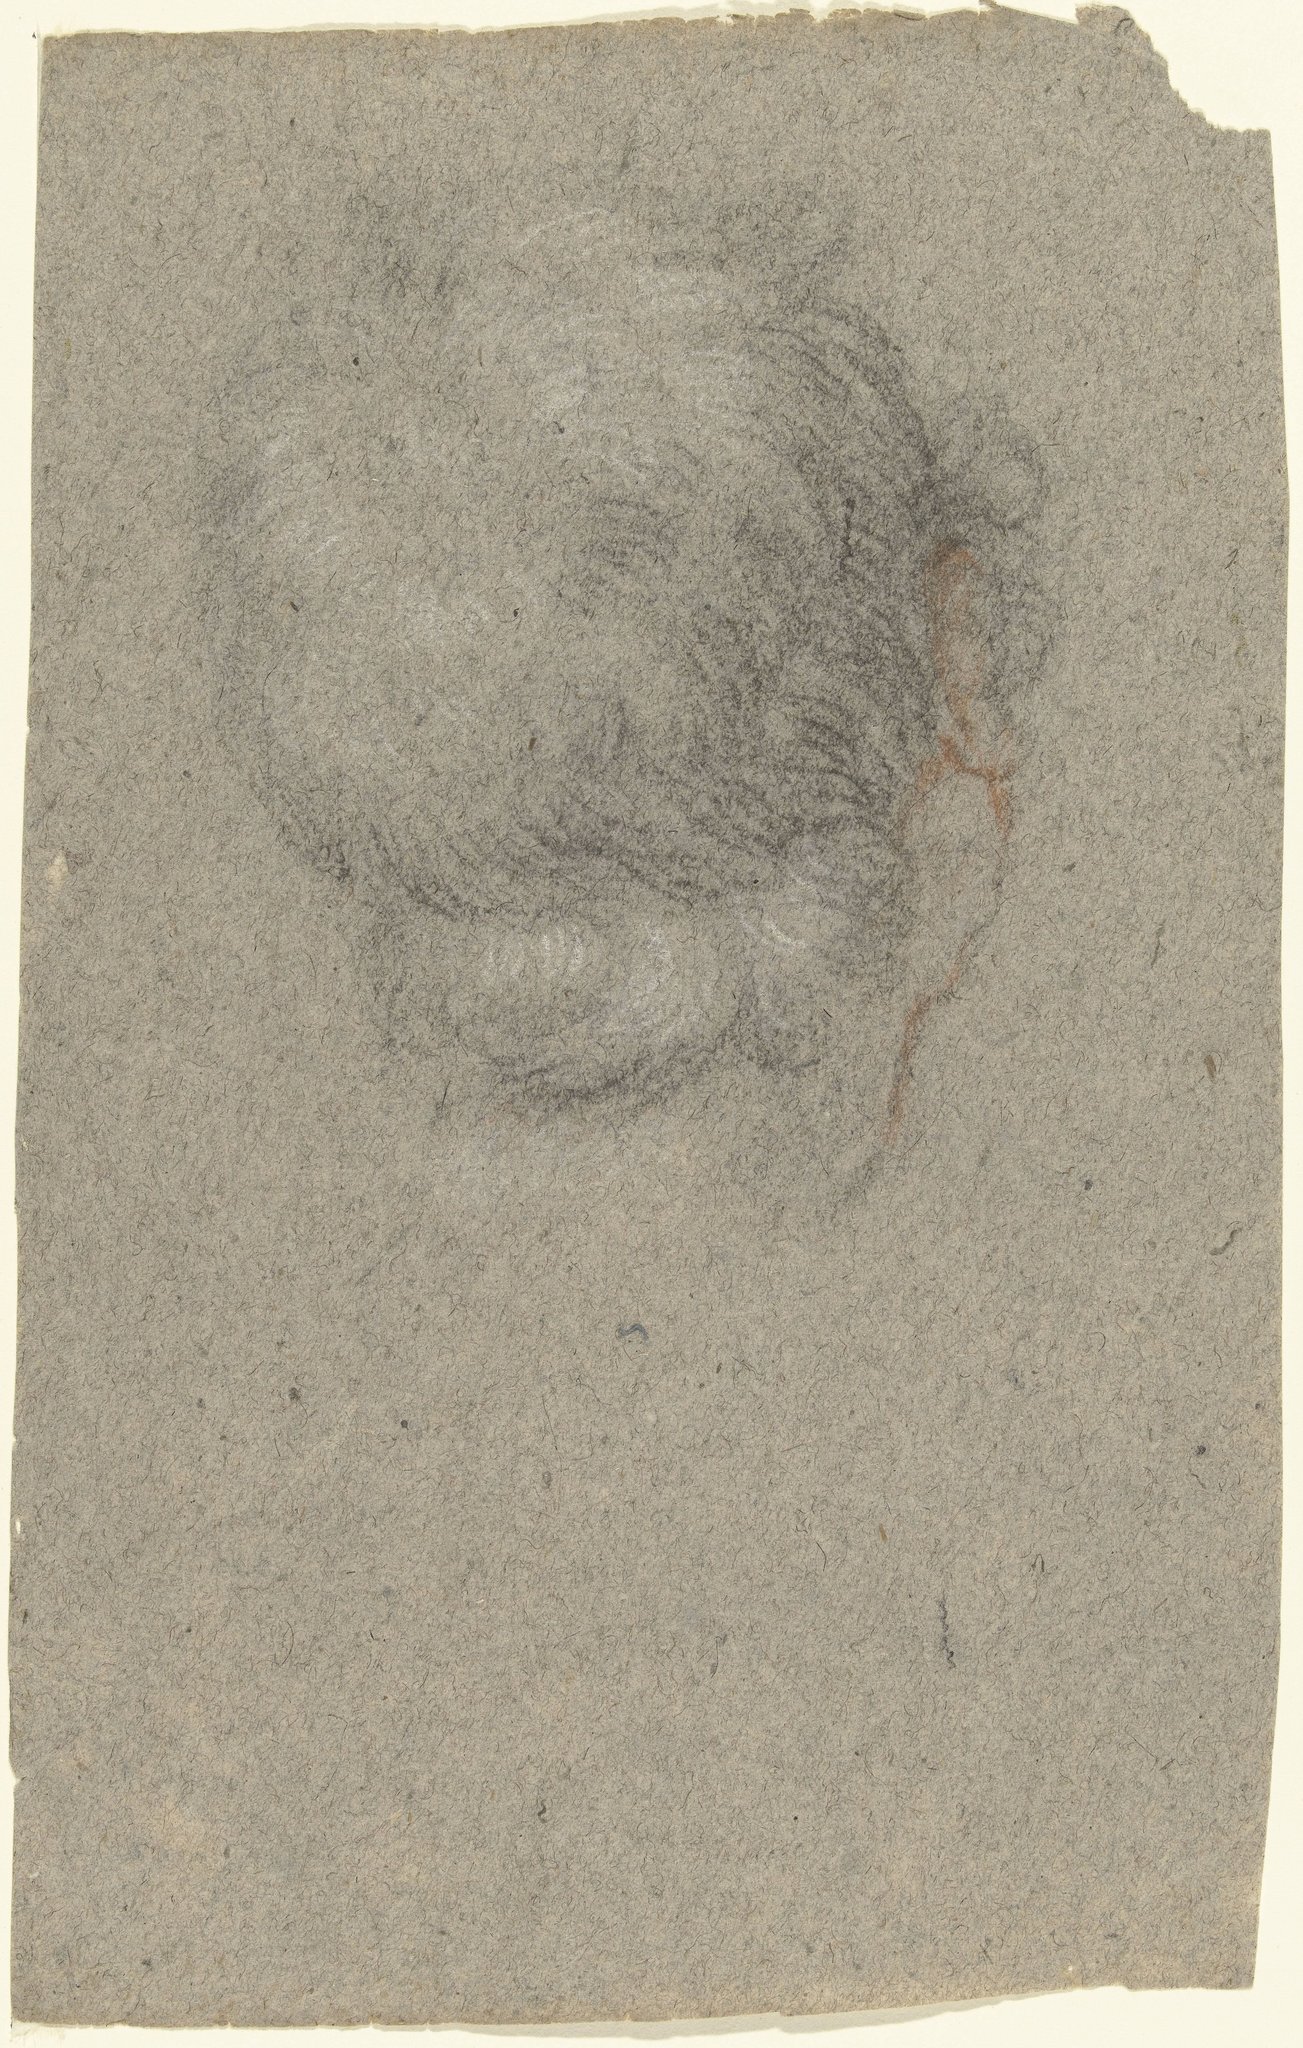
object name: drawing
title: Hoofd van een man, van achteren gezien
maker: Anonymous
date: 1590-1610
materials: paper, chalk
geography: northern italy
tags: head (human), male sex; man